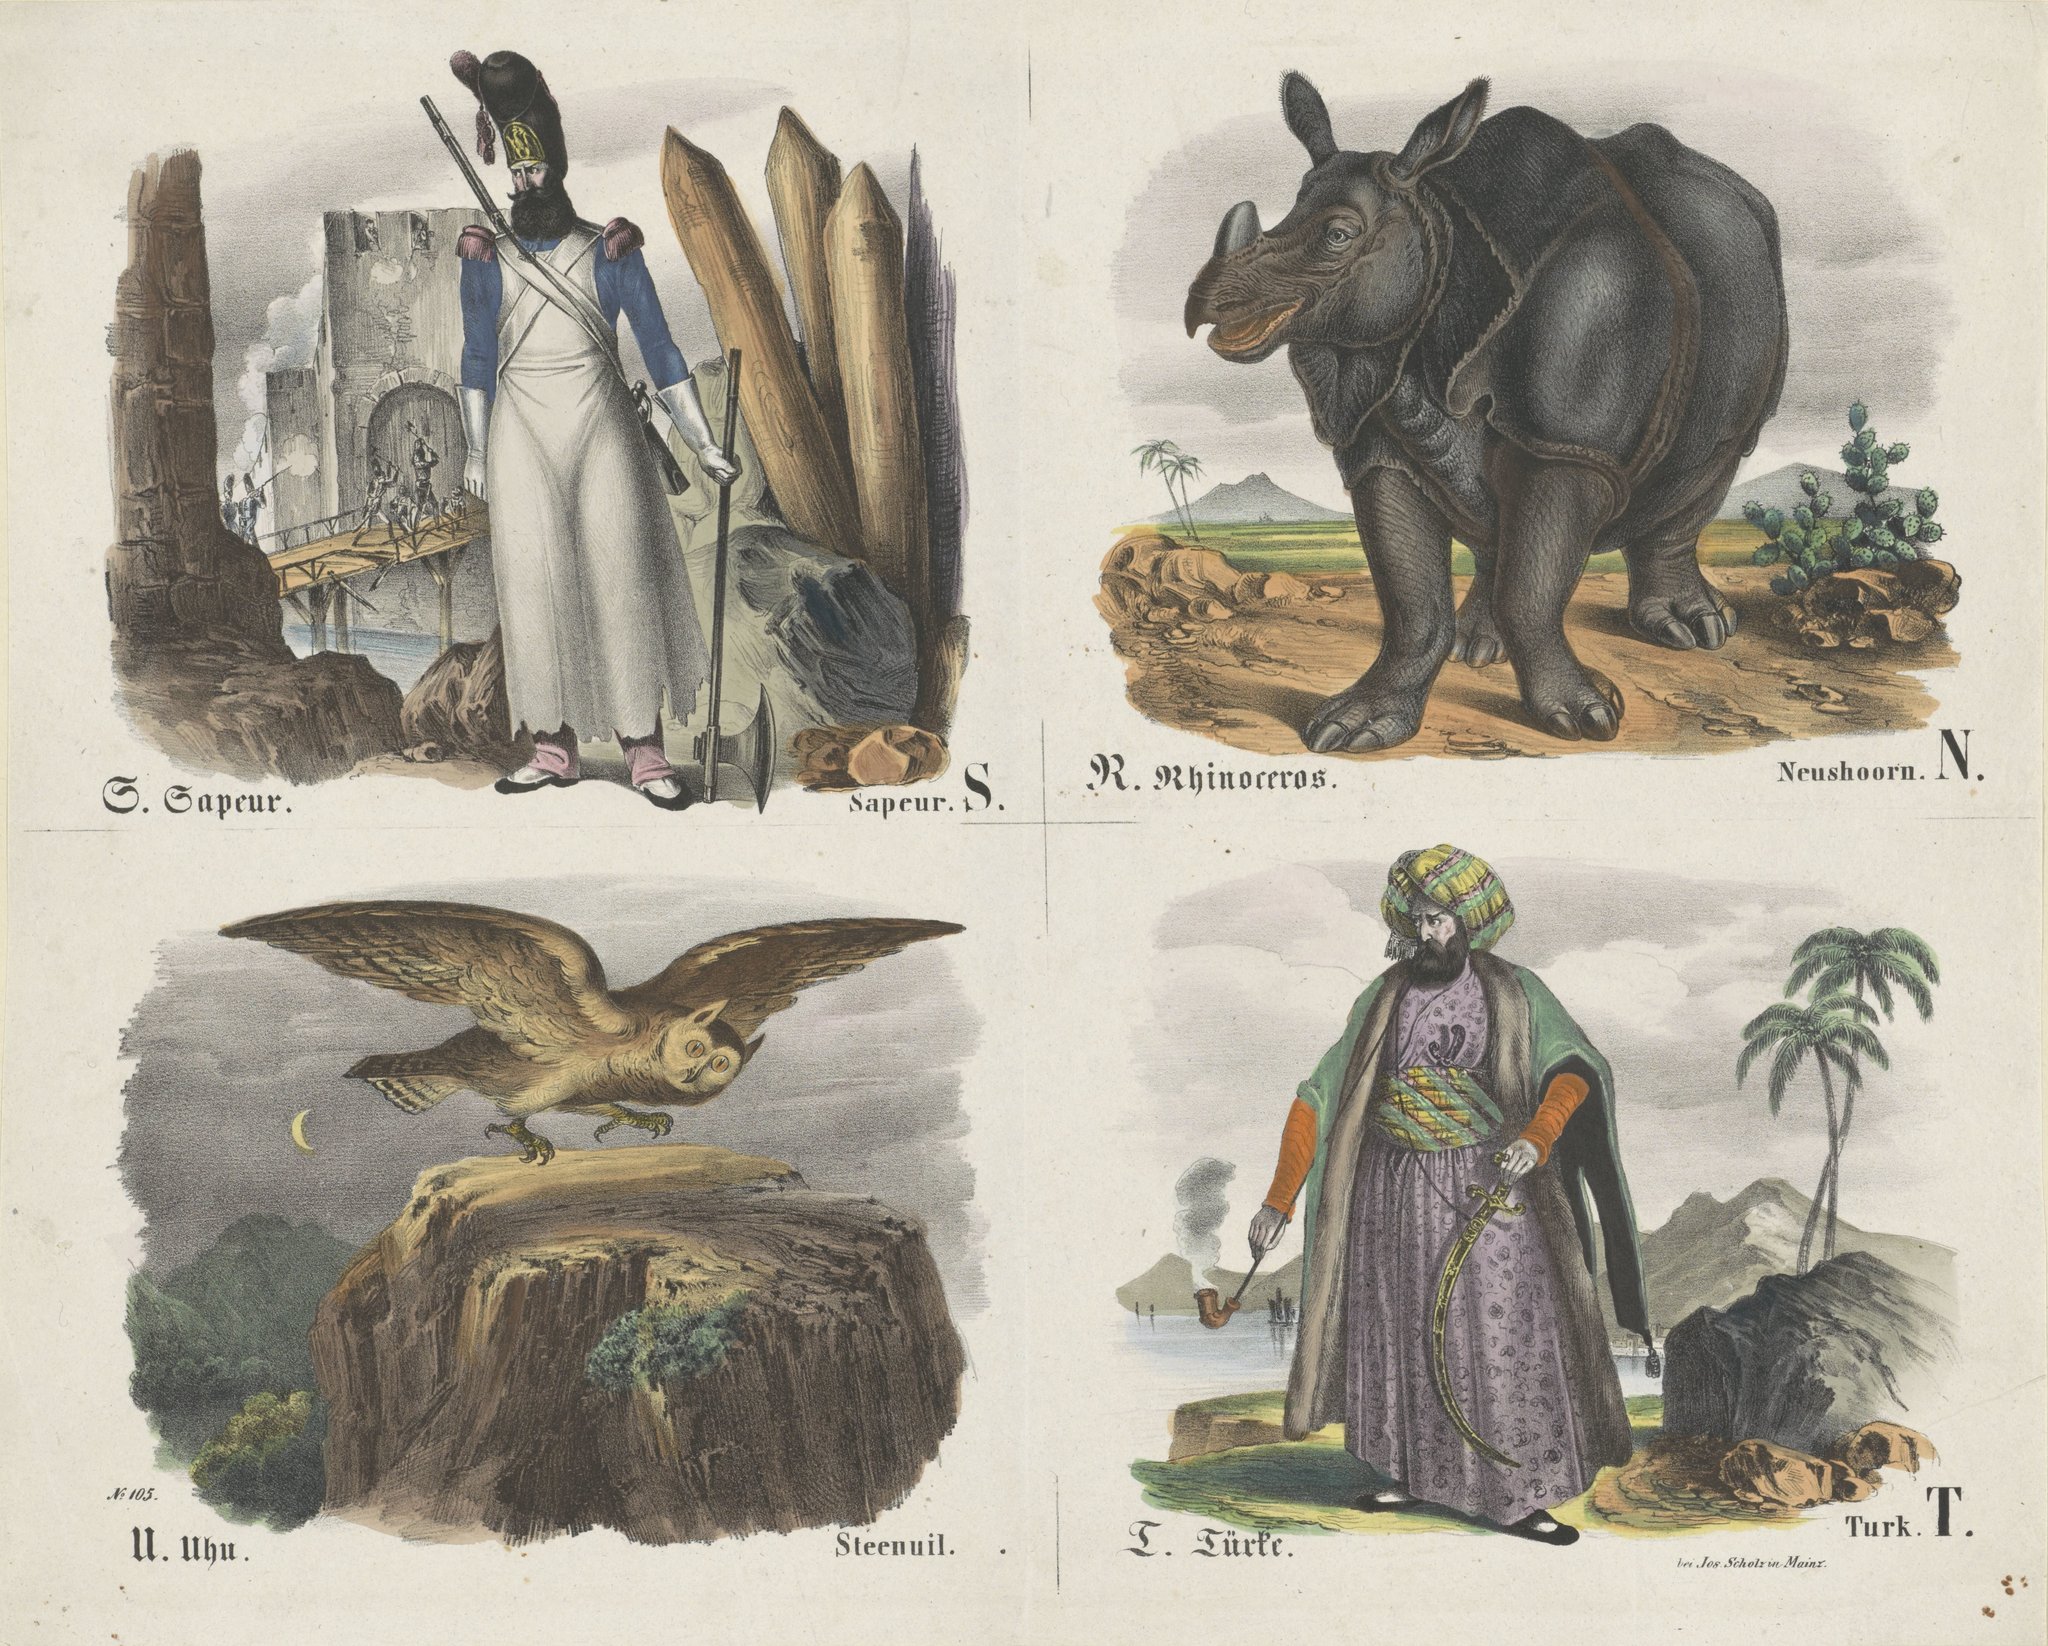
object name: popular print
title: Letters S, R, U en T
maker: Anonymous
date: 1829-1880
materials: paper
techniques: colour, lithograph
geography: mainz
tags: letters, alphabet, script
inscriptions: collector's mark: Lugt 2760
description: Blad met 4 voorstellingen om uit te knippen en samen tot boekje over het alfabet te binden. Verbeeldingen van de letters S (Sapeur), R (Rhinoceros = Neushoorn), U (uhu = Steenuil) en T (Turk). Onder elke afbeelding een onderschrift in het Duits en in het Nederlands. Genummerd linksonder: No. 105.